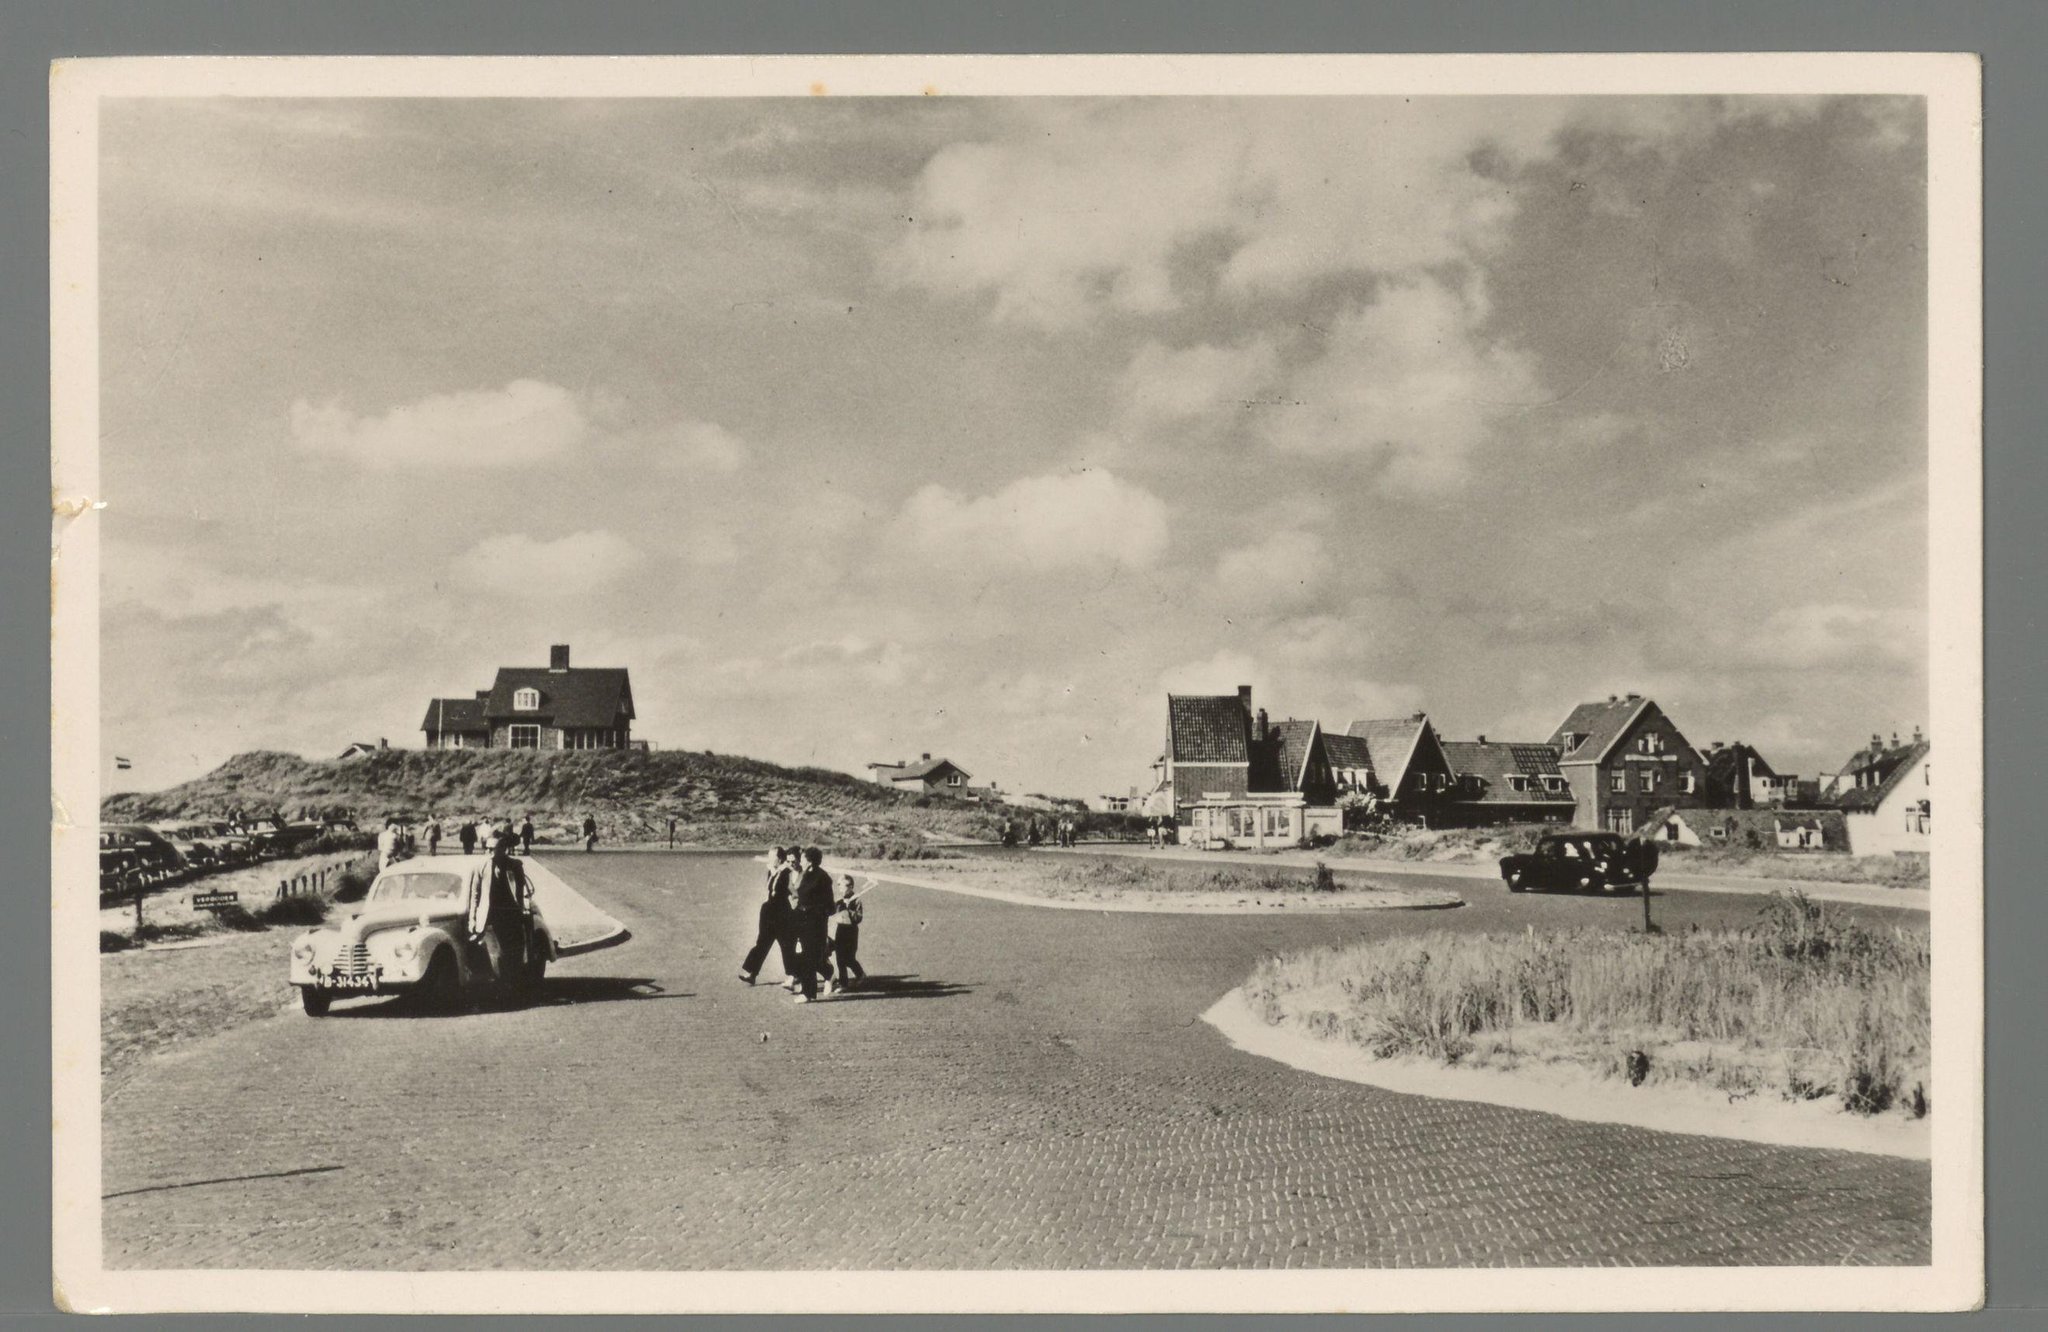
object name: ansichtkaart, prentbriefkaart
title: Strandpaviljoen "Ulysses" Onrust & Maasen Bergen aan Zee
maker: Anonymous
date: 1929-1951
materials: photographic support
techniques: photography, writing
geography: bergen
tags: city-view, and landscape with man-made constructions, dunes (sea not visible); in the dunes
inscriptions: postage stamp, stamp: ‘CS’